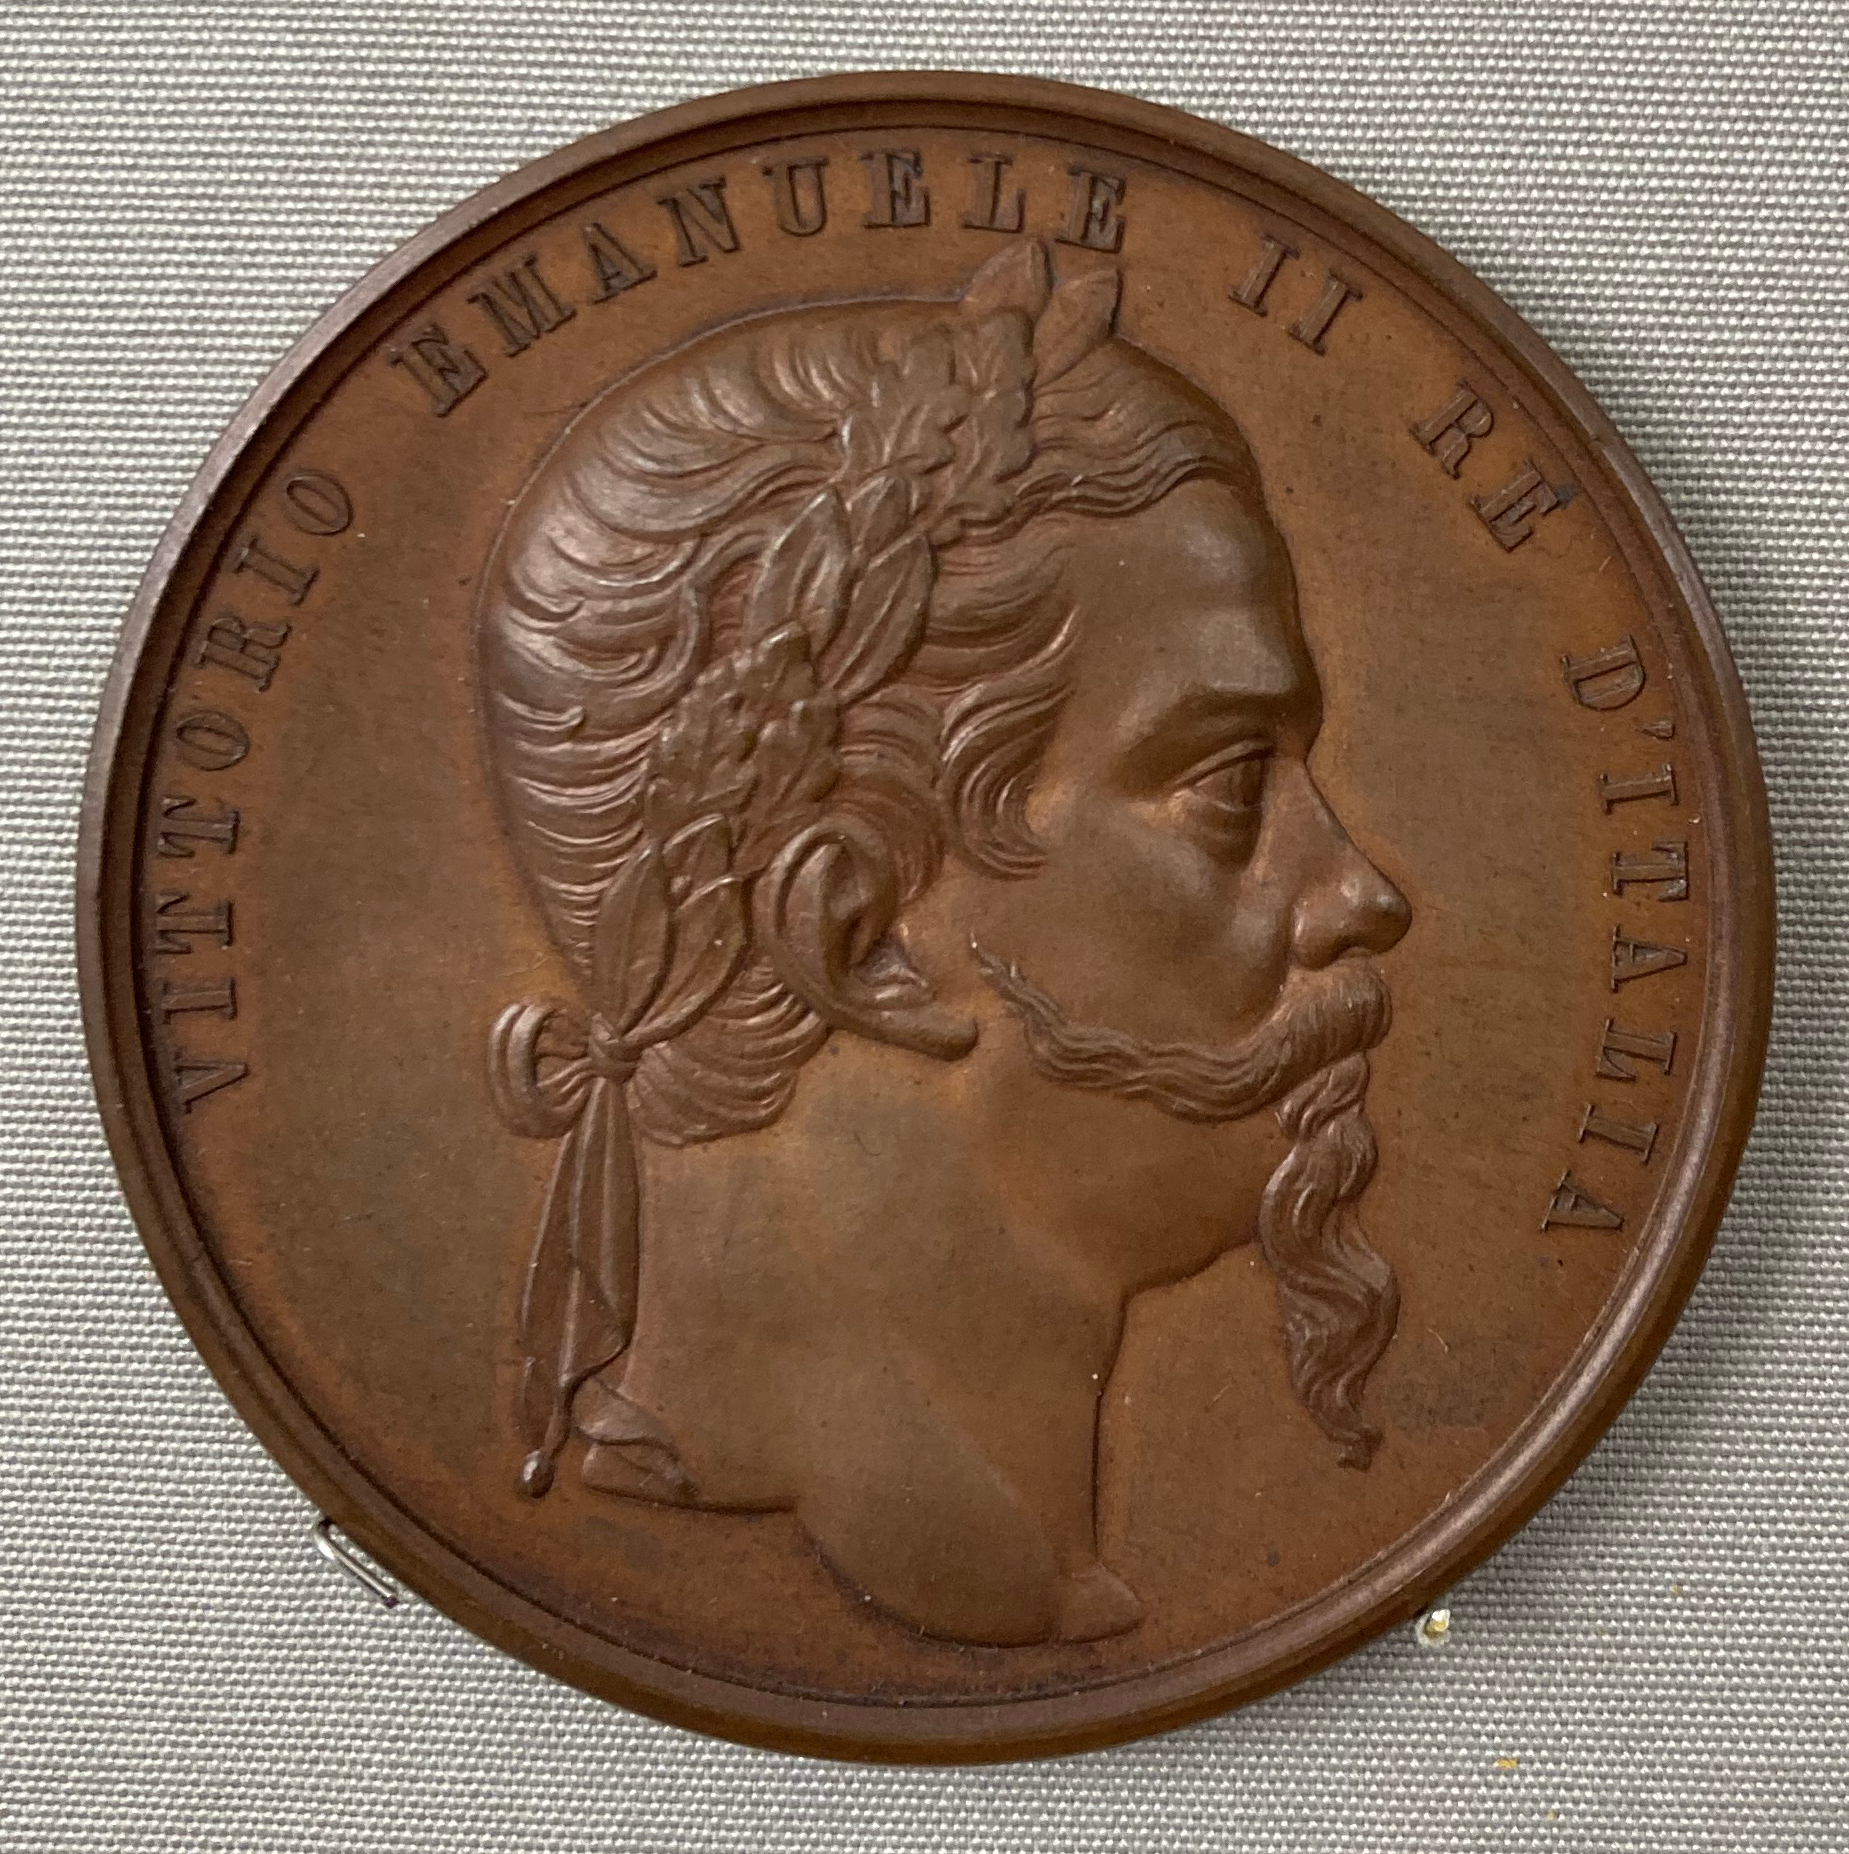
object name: medal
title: Complimentary Medal of Victor Emanuel, King of Italy, on the Completion of the Suez Canal, 1869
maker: e. trotin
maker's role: artist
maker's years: 1800-1900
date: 1869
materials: bronze